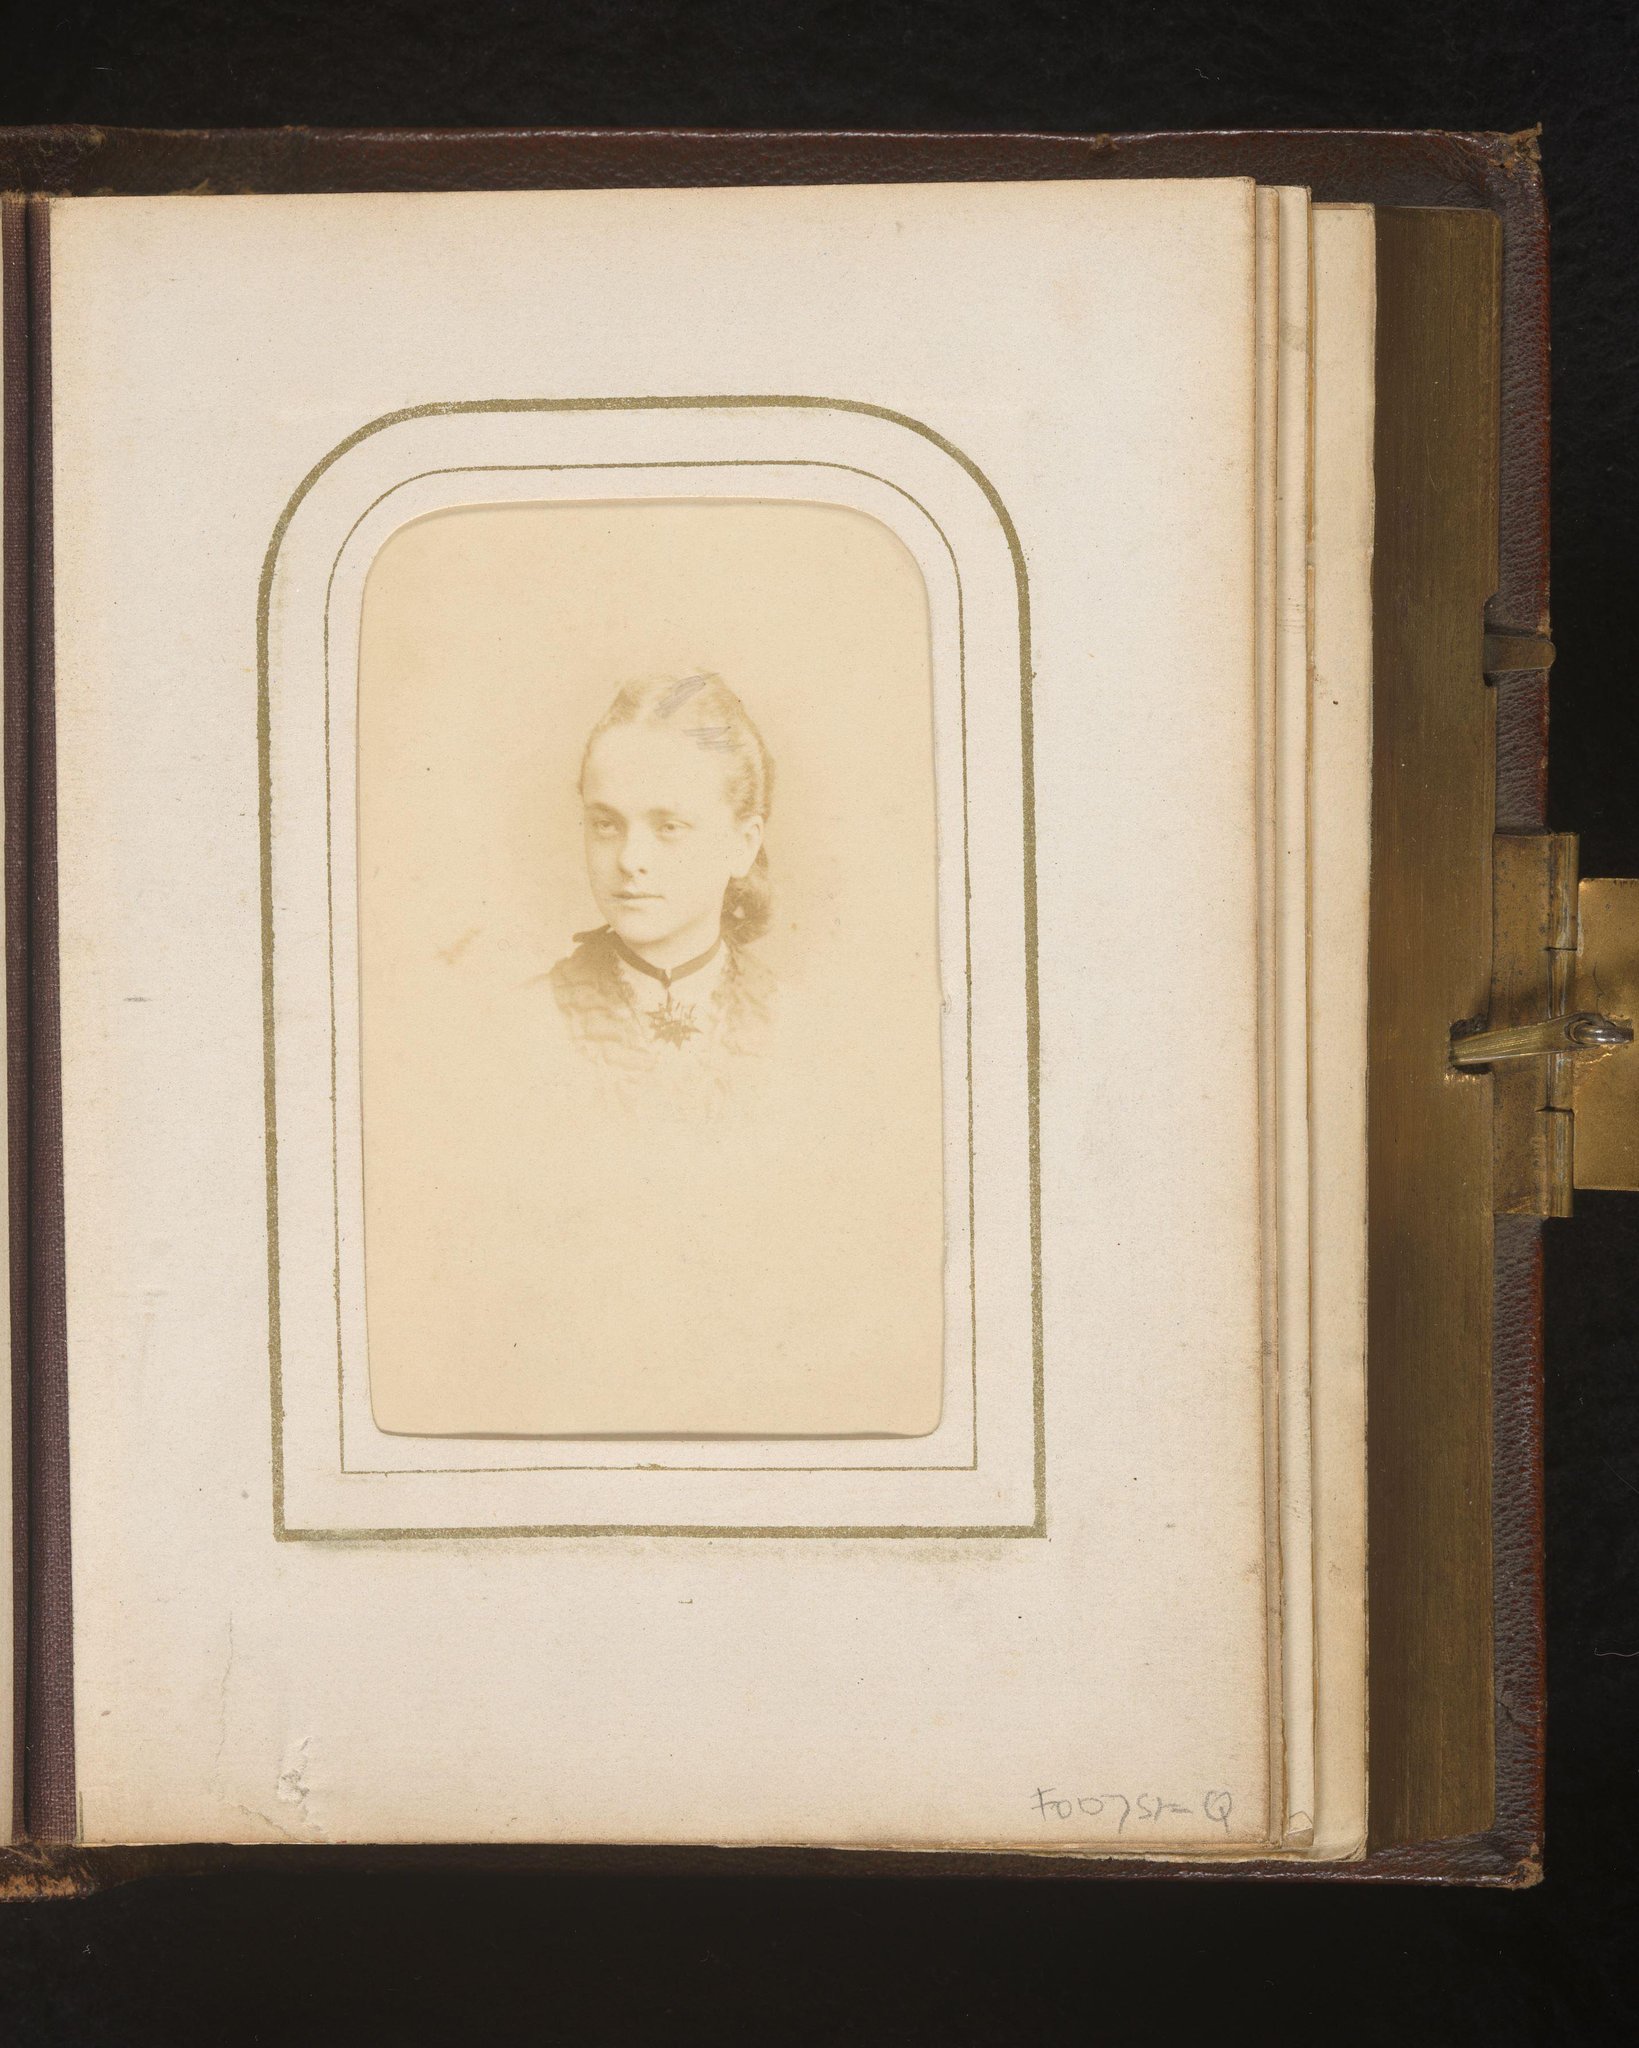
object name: album leaf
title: Portret van een meisje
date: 1860-1880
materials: cardboard, photographic support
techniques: albumen print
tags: adolescent, young woman, maiden, historical persons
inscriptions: number: ‘56139’, inscription: ‘Elliott & Fry/ 55, Baker Street/ Portman Square. W.’